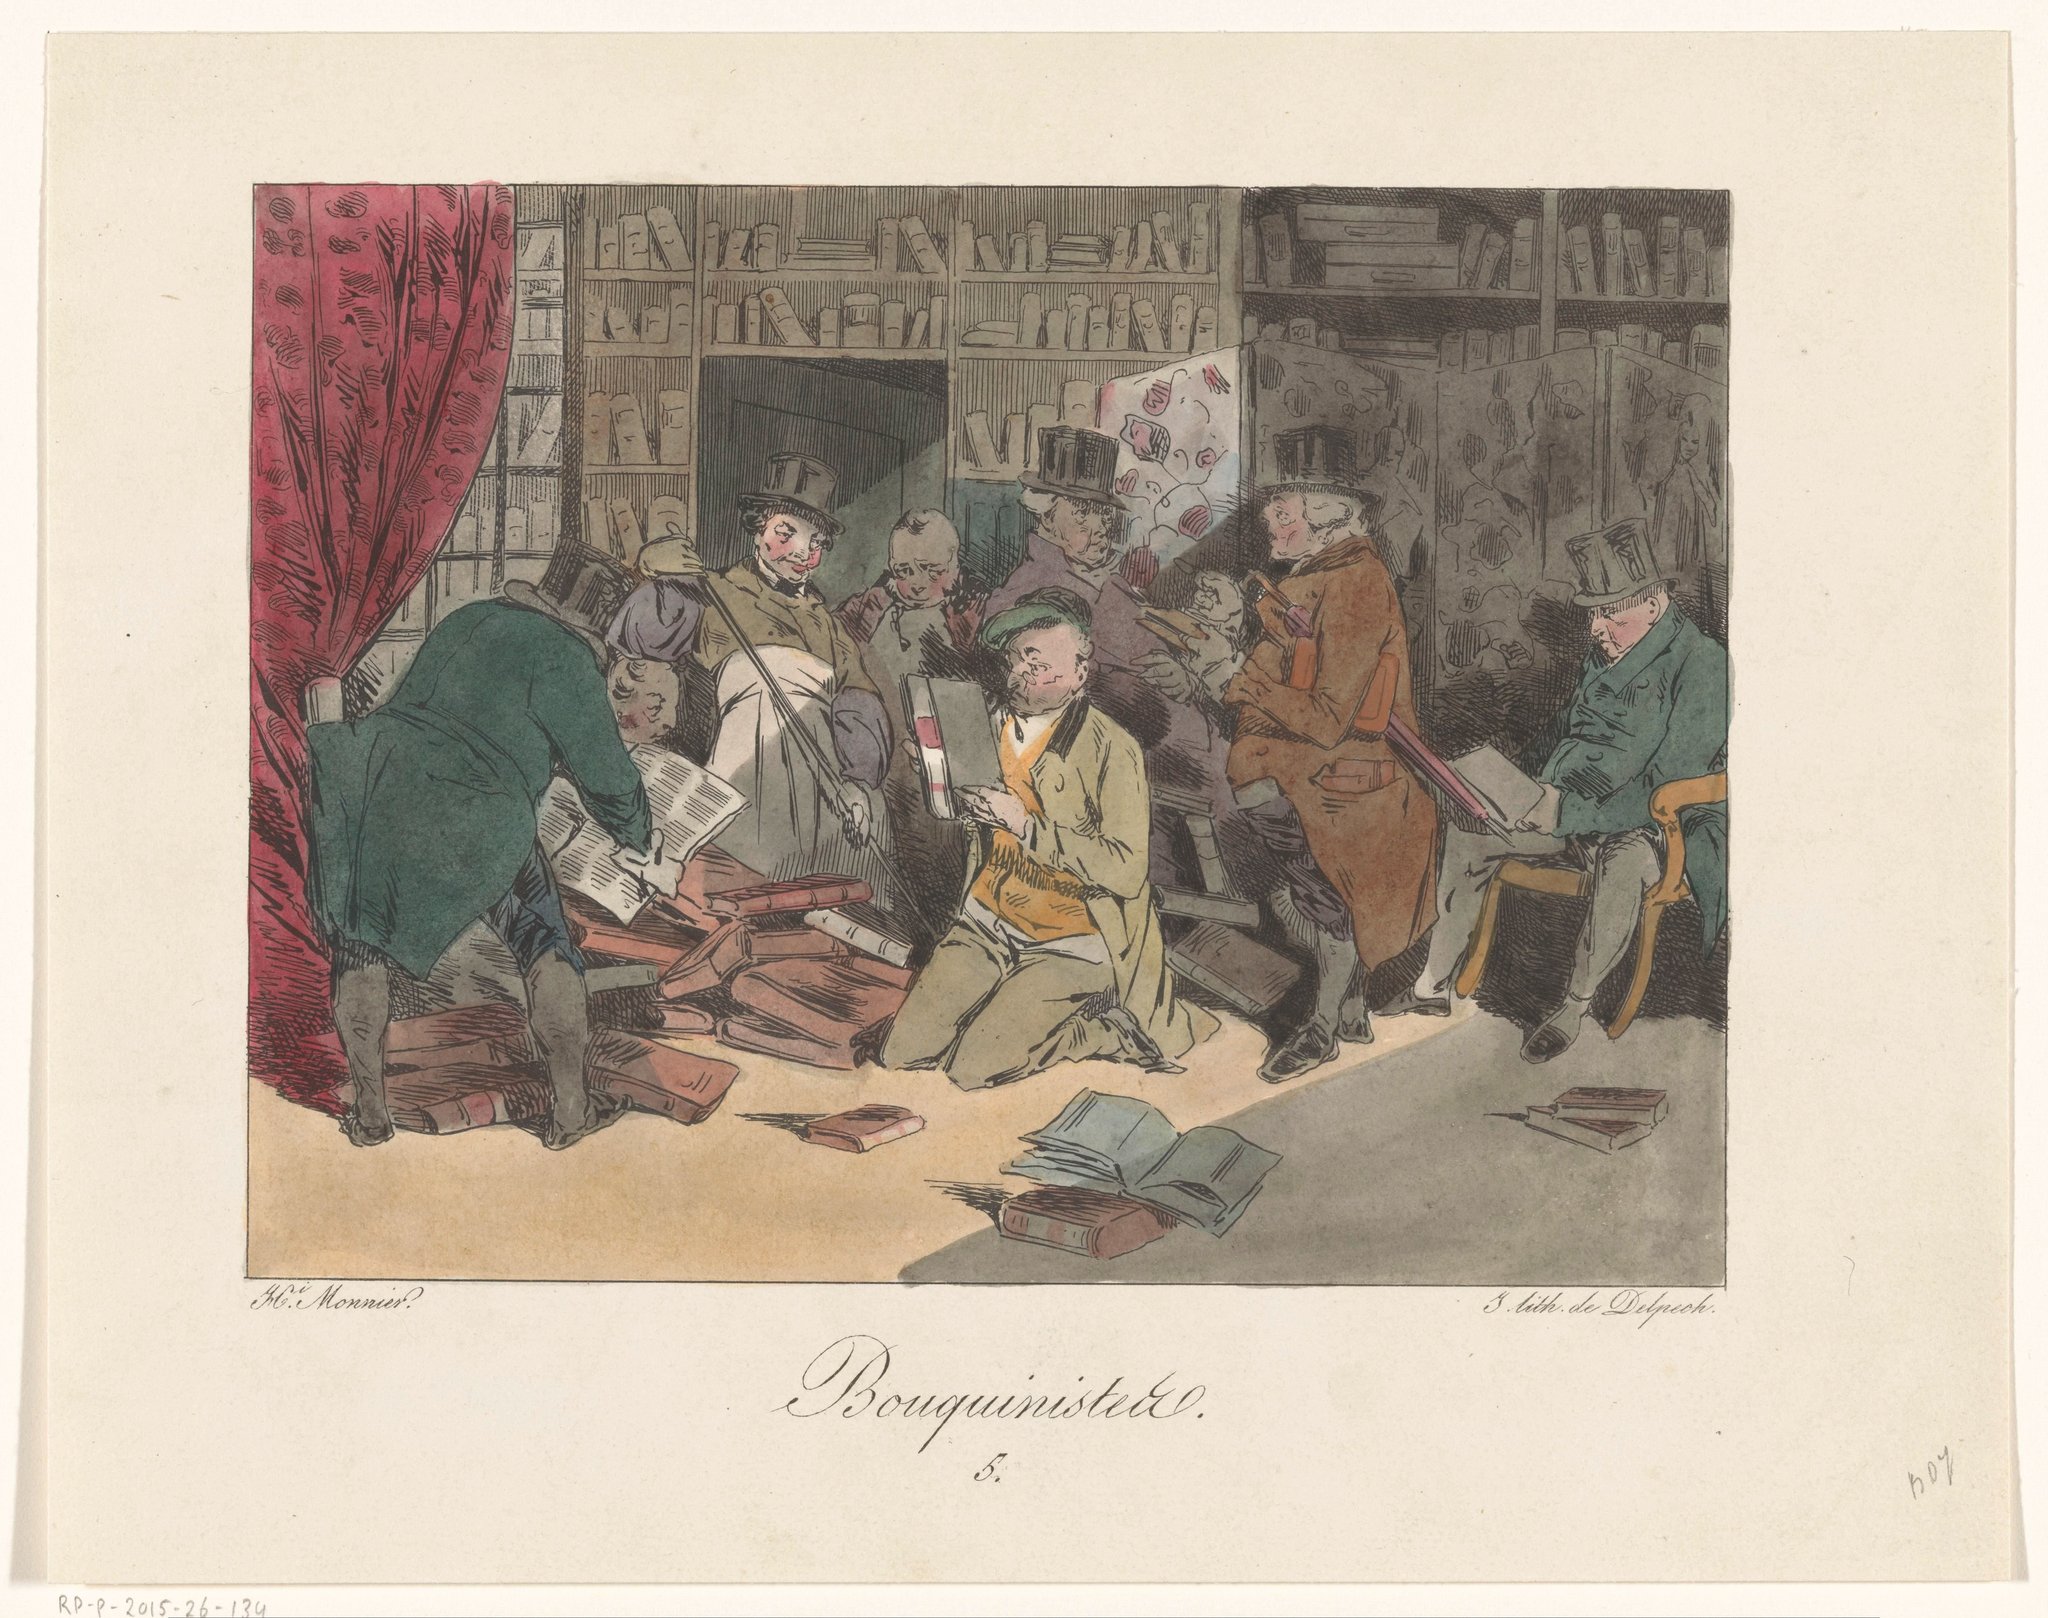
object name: print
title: Boutiques de Paris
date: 1829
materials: paper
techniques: hand coloring, lithograph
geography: paris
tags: reading, study; 'studiolo'; library, merchant, salesman, paris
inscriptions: collector's mark: Lugt 4780, collector's mark: Lugt 4779, collector's mark: Lugt 2228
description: Waarschijnlijk gaat het om boekhandelaren die een privé-bibliotheek inspecteren die verkocht moet worden. Onder genummerd: 5.